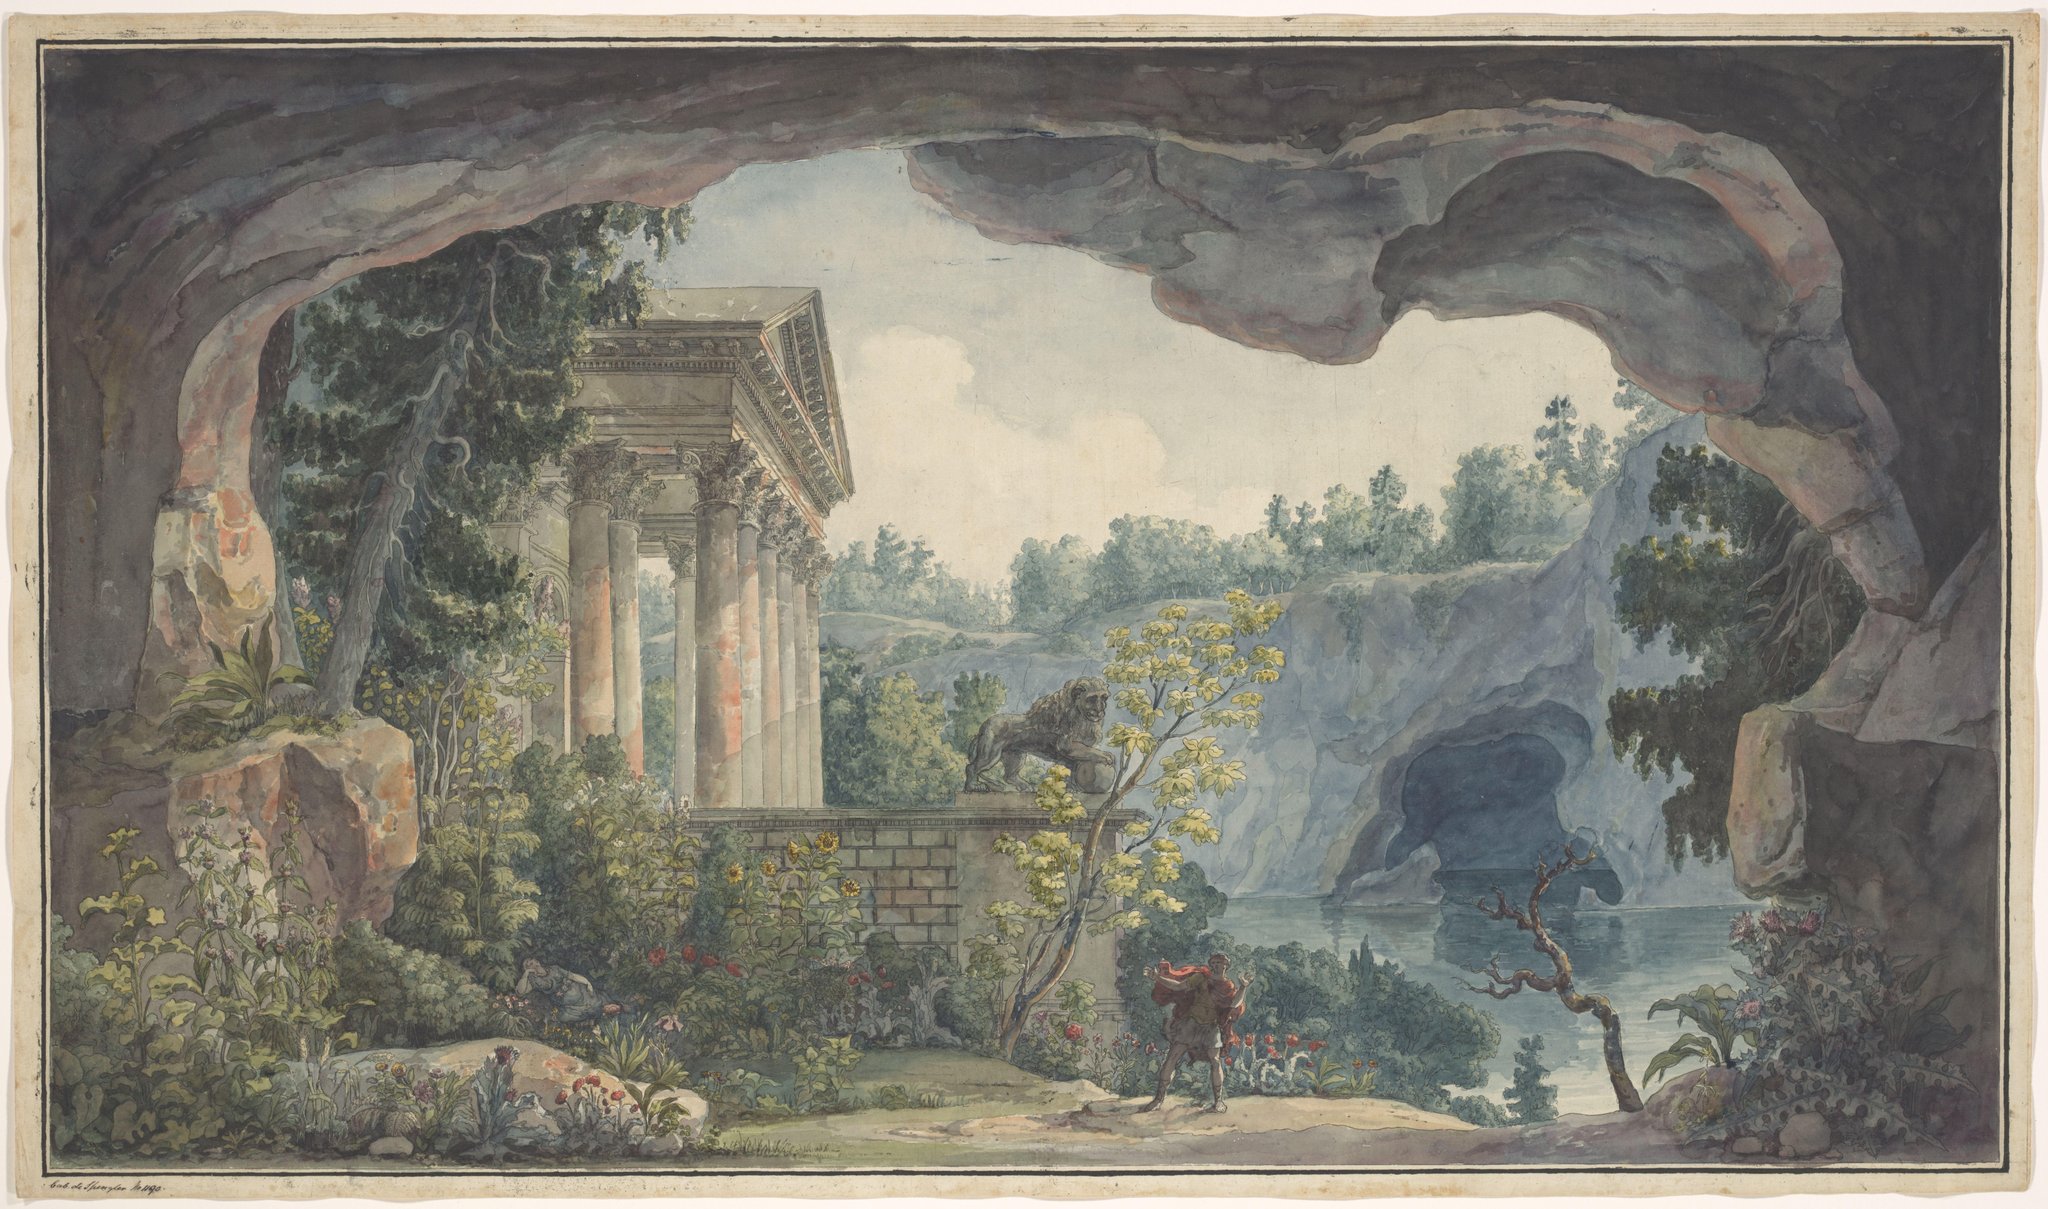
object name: print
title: Theaterdecor voor de opera Frigga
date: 1787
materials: paper, watercolor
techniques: brush, etching, hand coloring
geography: stockholm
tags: opera, stage design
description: Tussen 1784 en 1792 verbleef Louis Jean Deprez aan het hof van de Zweedse koning Gustav III, waar hij talloze ontwerpen voor o.a. theaterdecors vervaardigde. Dit is een ontwerp voor de komische opera Frigga, waarvoor Gustav III zelf het libretto schreef. Het ontwerp is door twee van Desprez's leerlingen in prent gebracht en ingekleurd. Vanuit een grot gezien links een tempel met korinthische zuilen en rechts een man in een rode mantel op de oever van een meer.